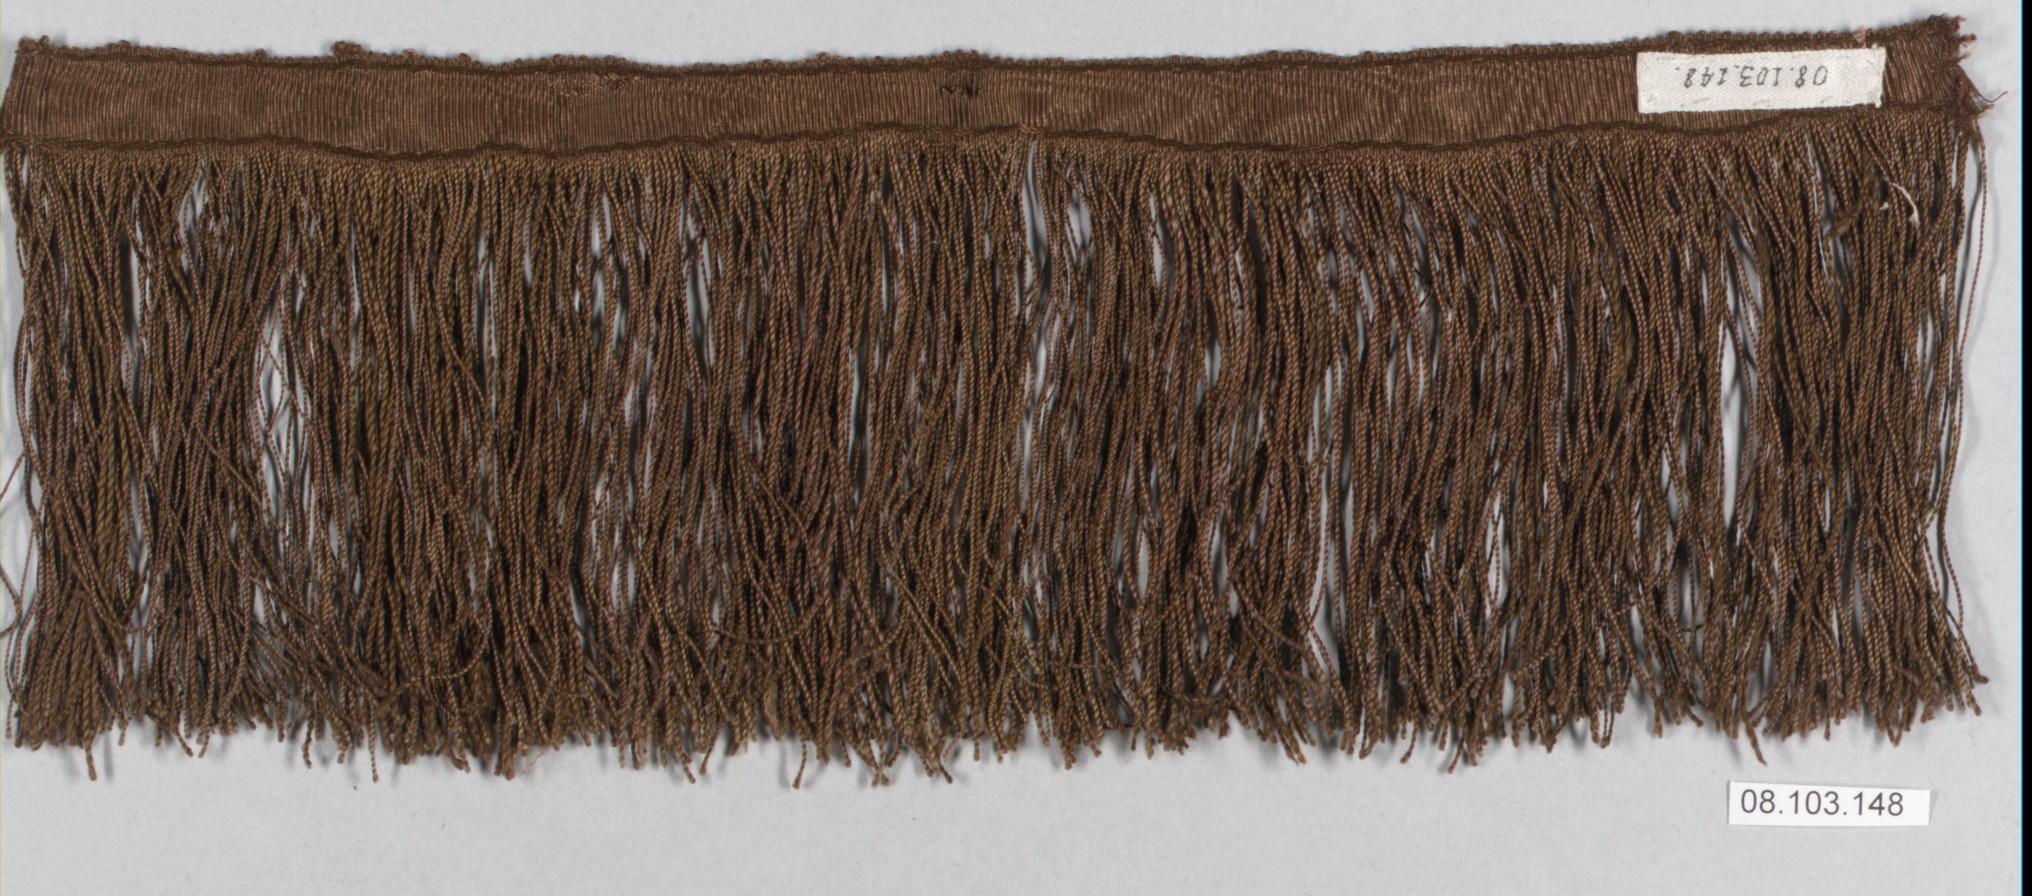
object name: fringe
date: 1801-1900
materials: silk